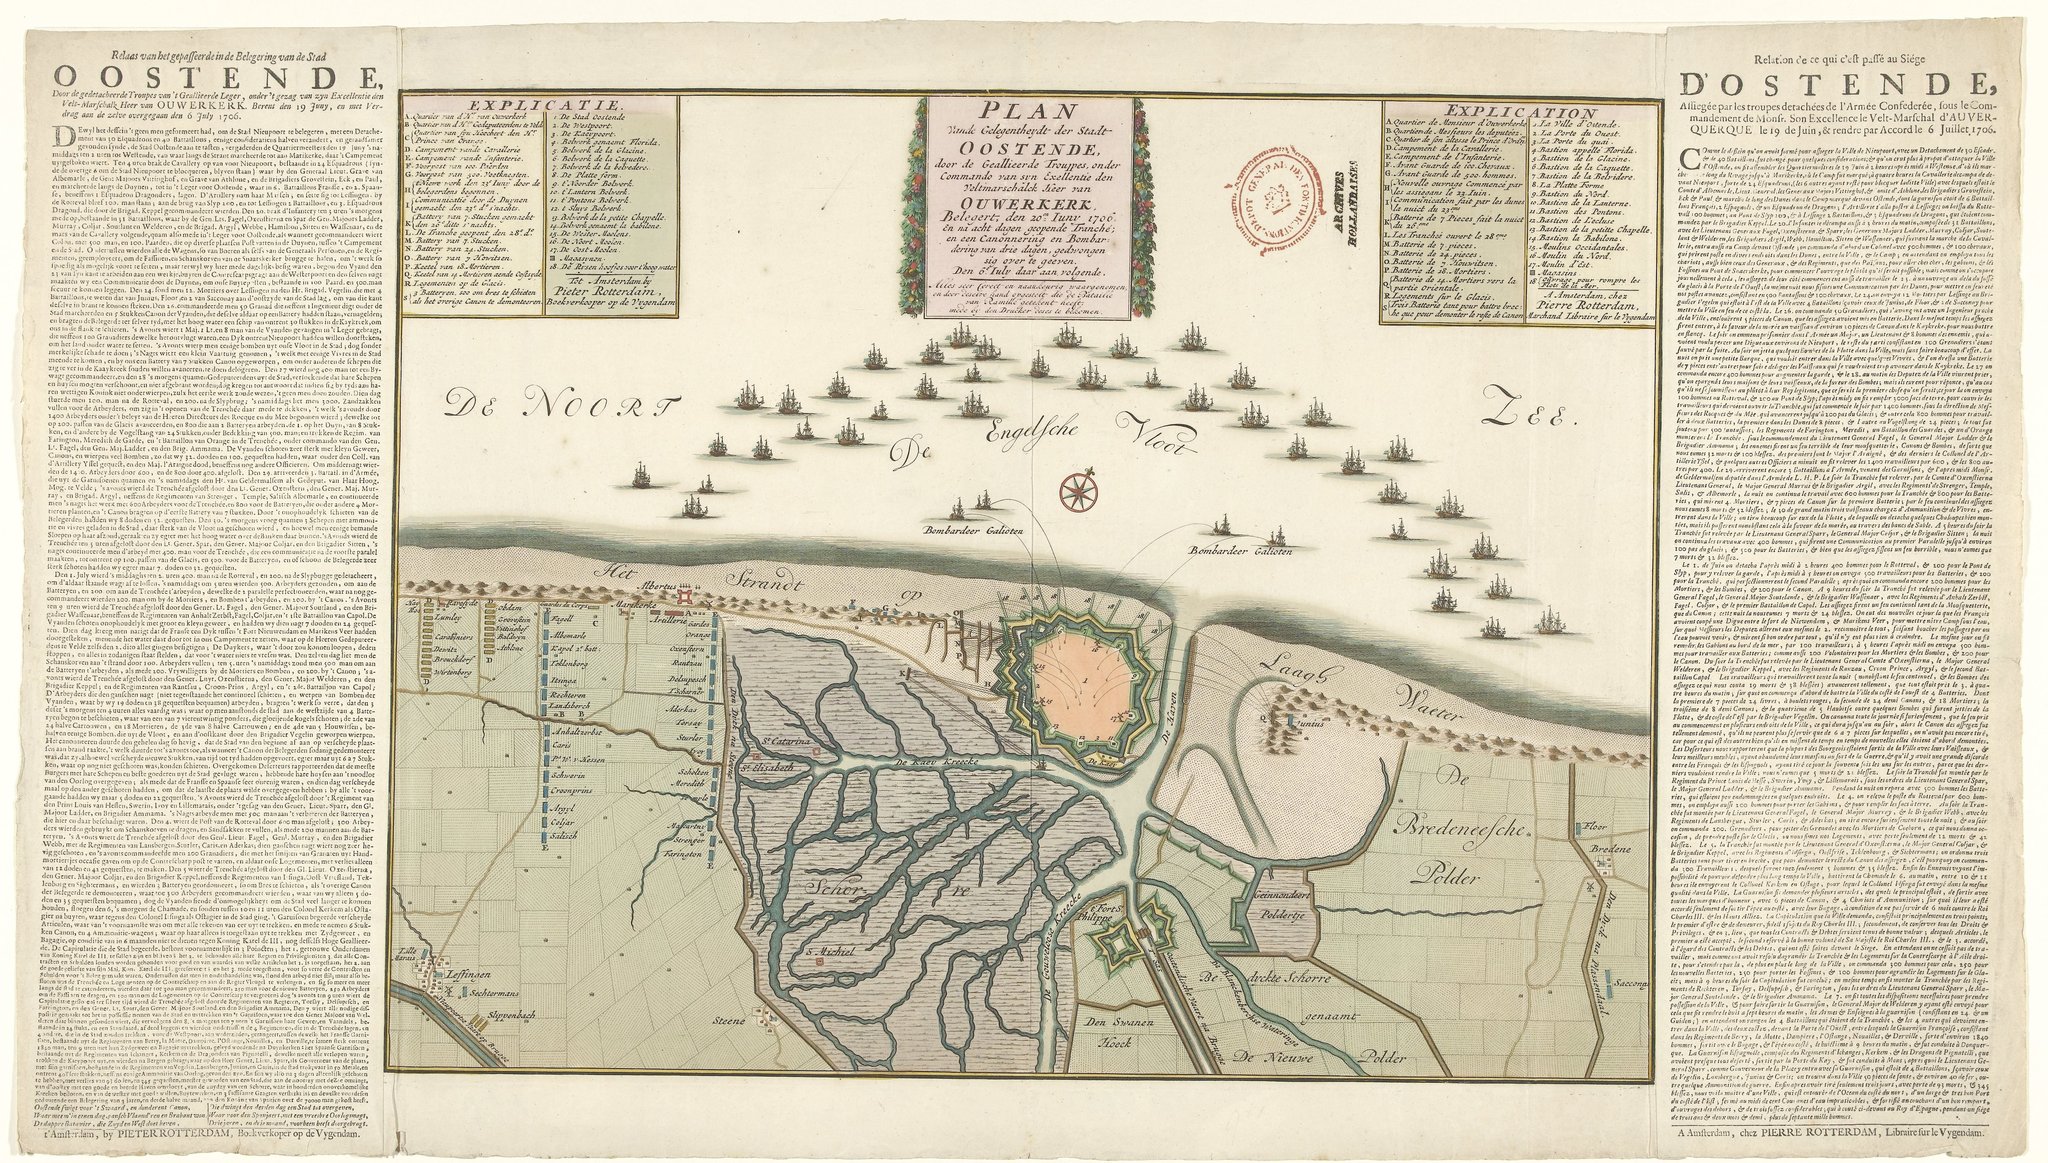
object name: map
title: Plan Vande Gelegentheydt der Stadt Oostende, door de Geallieerde Trouppes, onder Commando van syn Excellentie den Veltmarschalck Heer van Ouwerkerk, Belegert, den 20.en Juny 1706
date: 1706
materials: paper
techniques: etching, hand coloring, letterpress printing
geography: northern netherlands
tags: maps of separate countries or regions, siege, position war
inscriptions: collector's mark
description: Kaart van het beleg van Oostende door de Geallieerden onder Hendrik van Nassau, heer van Ouwerkerk, belegerd vanaf 17 juni, ingenomen op 6 juli 1706. Bovenaan cartouches met de legenda's A-S en 1-18 in het Frans en Nederlands. Aan weerszijden van de kaart zijn tekstbladen geplakt met een relaas van het beleg in het Nederlands en Frans.